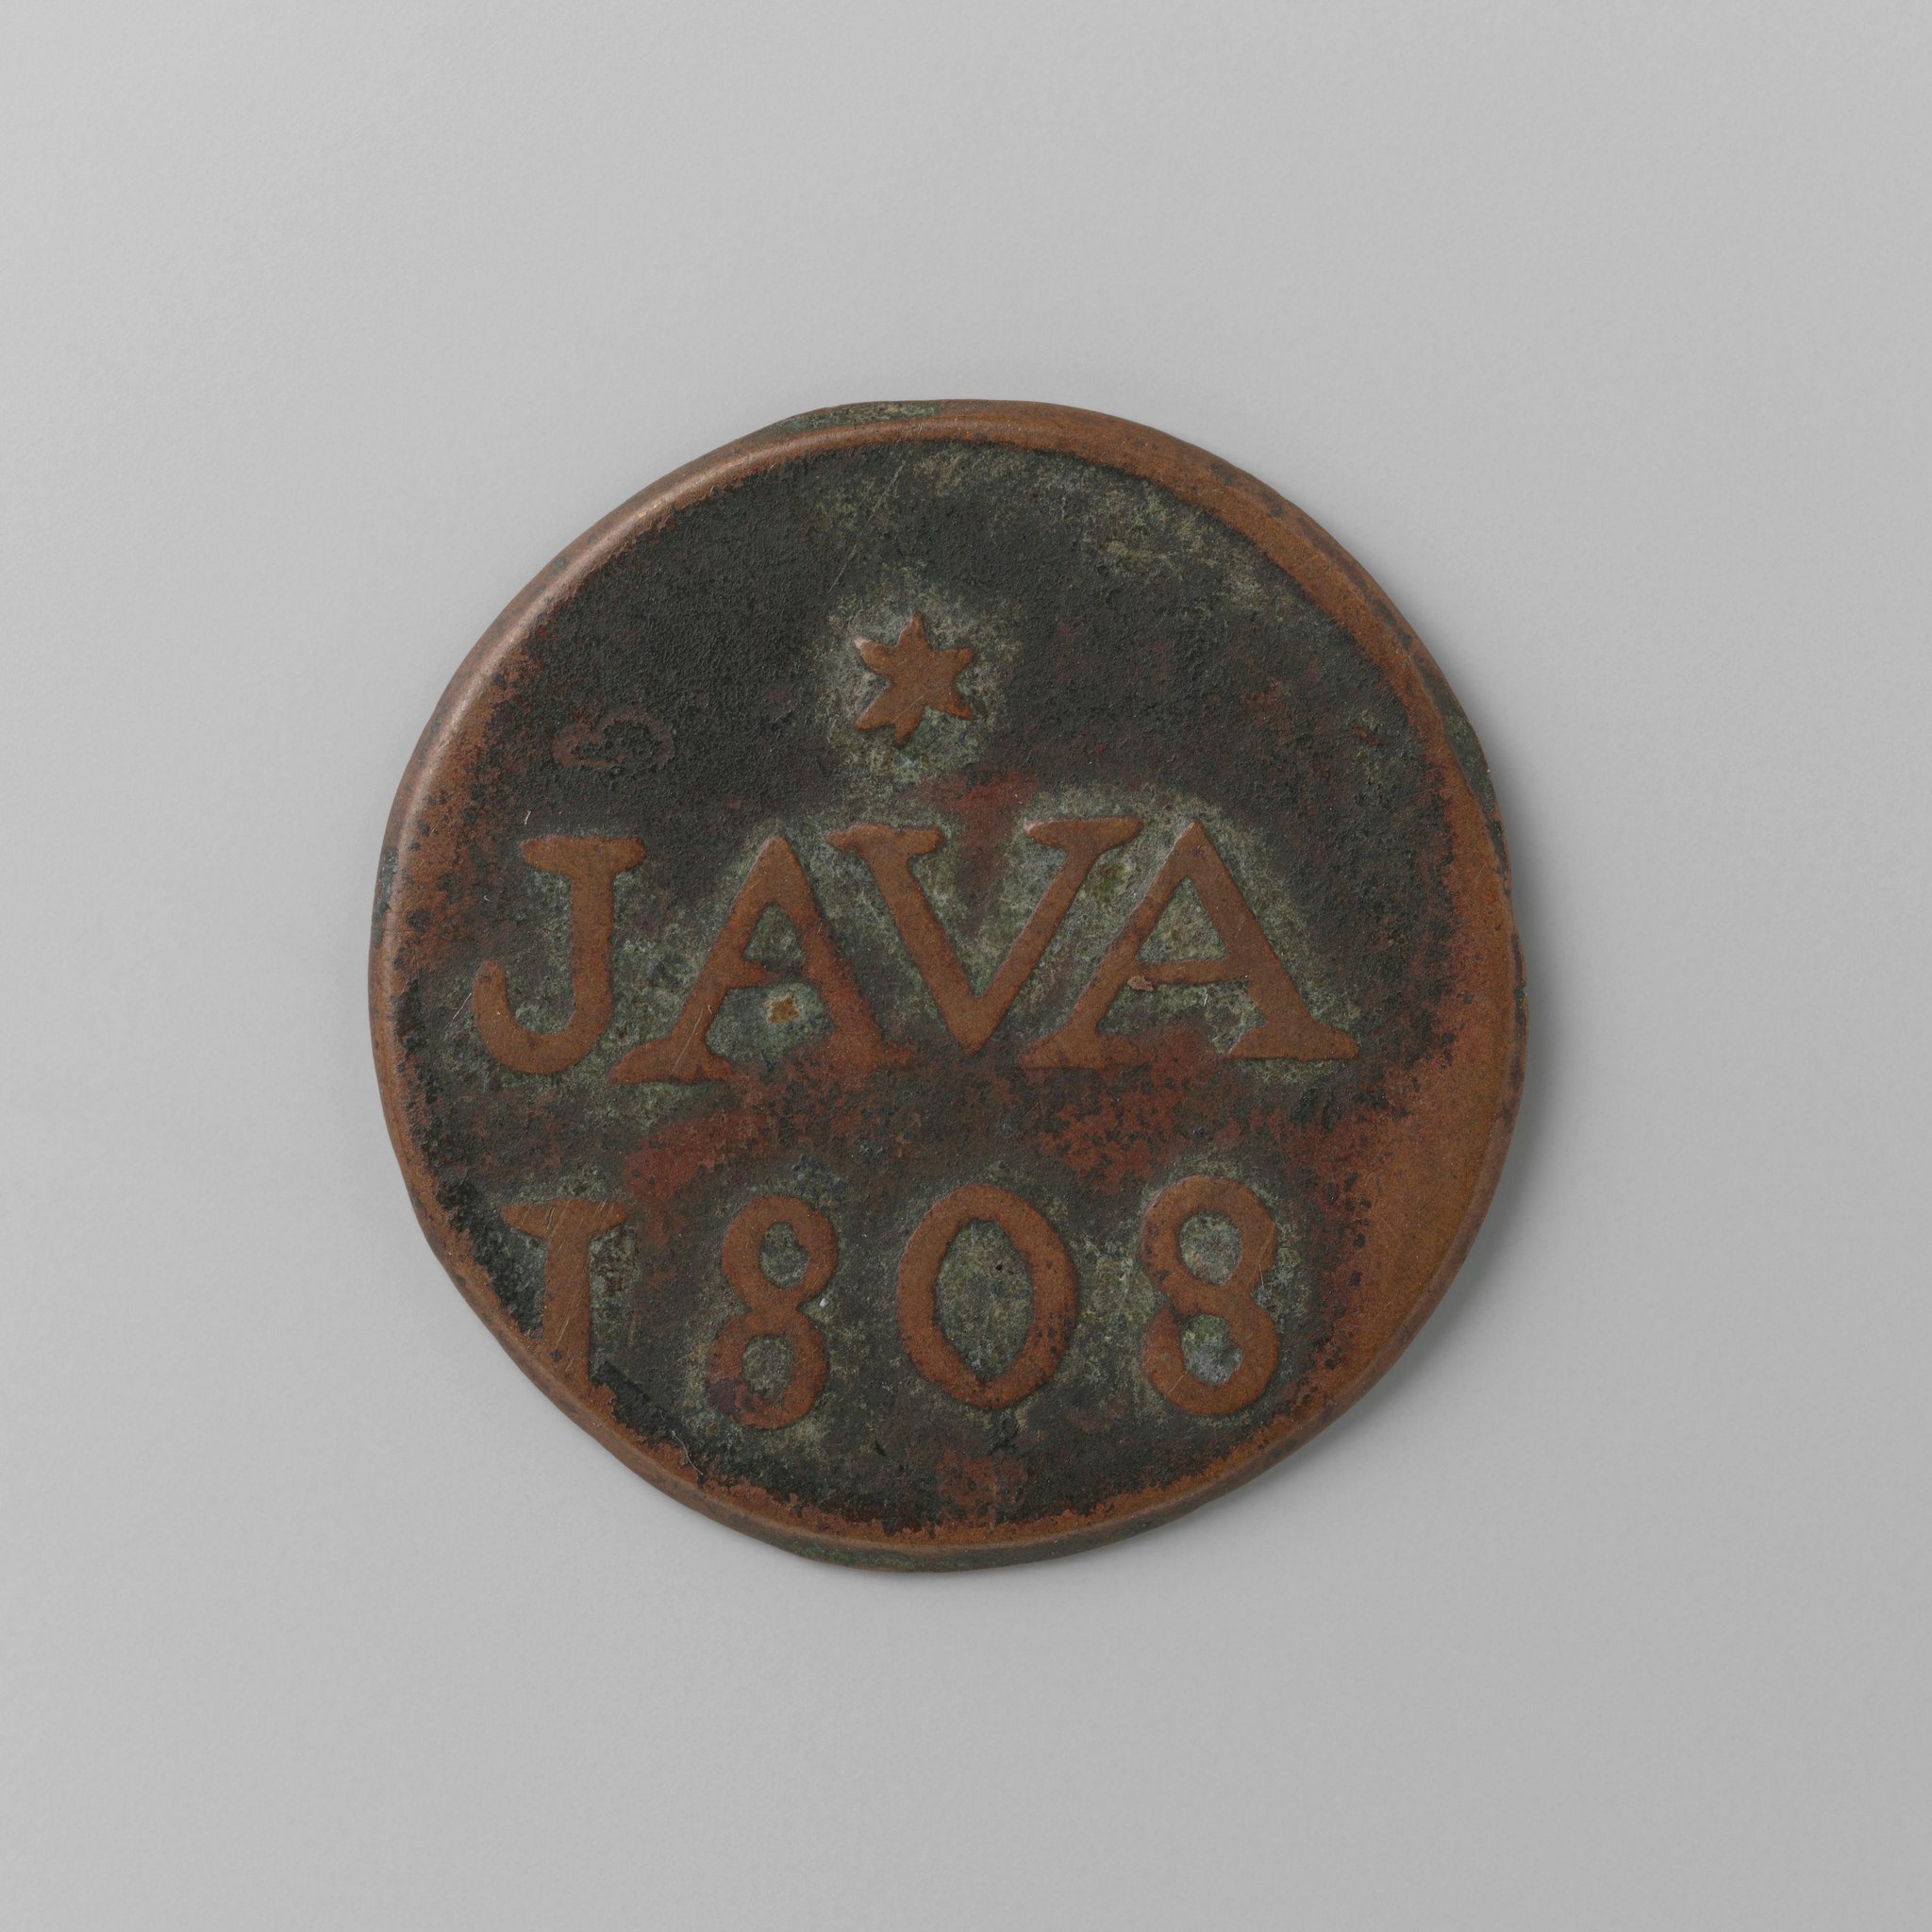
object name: coin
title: Nederlands Indië, duit Java,1808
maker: louis napoleon (king of holland)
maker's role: koning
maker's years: 1778-1846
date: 1808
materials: copper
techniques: striking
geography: surabaya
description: Koperen munt. Voorzijde: initialen L en N van Lodewijk Napoleon. Daarboven muntteken. Keerzijde: eenregelig opschrift, waaronder jaartal. Boven opschrift muntteken.